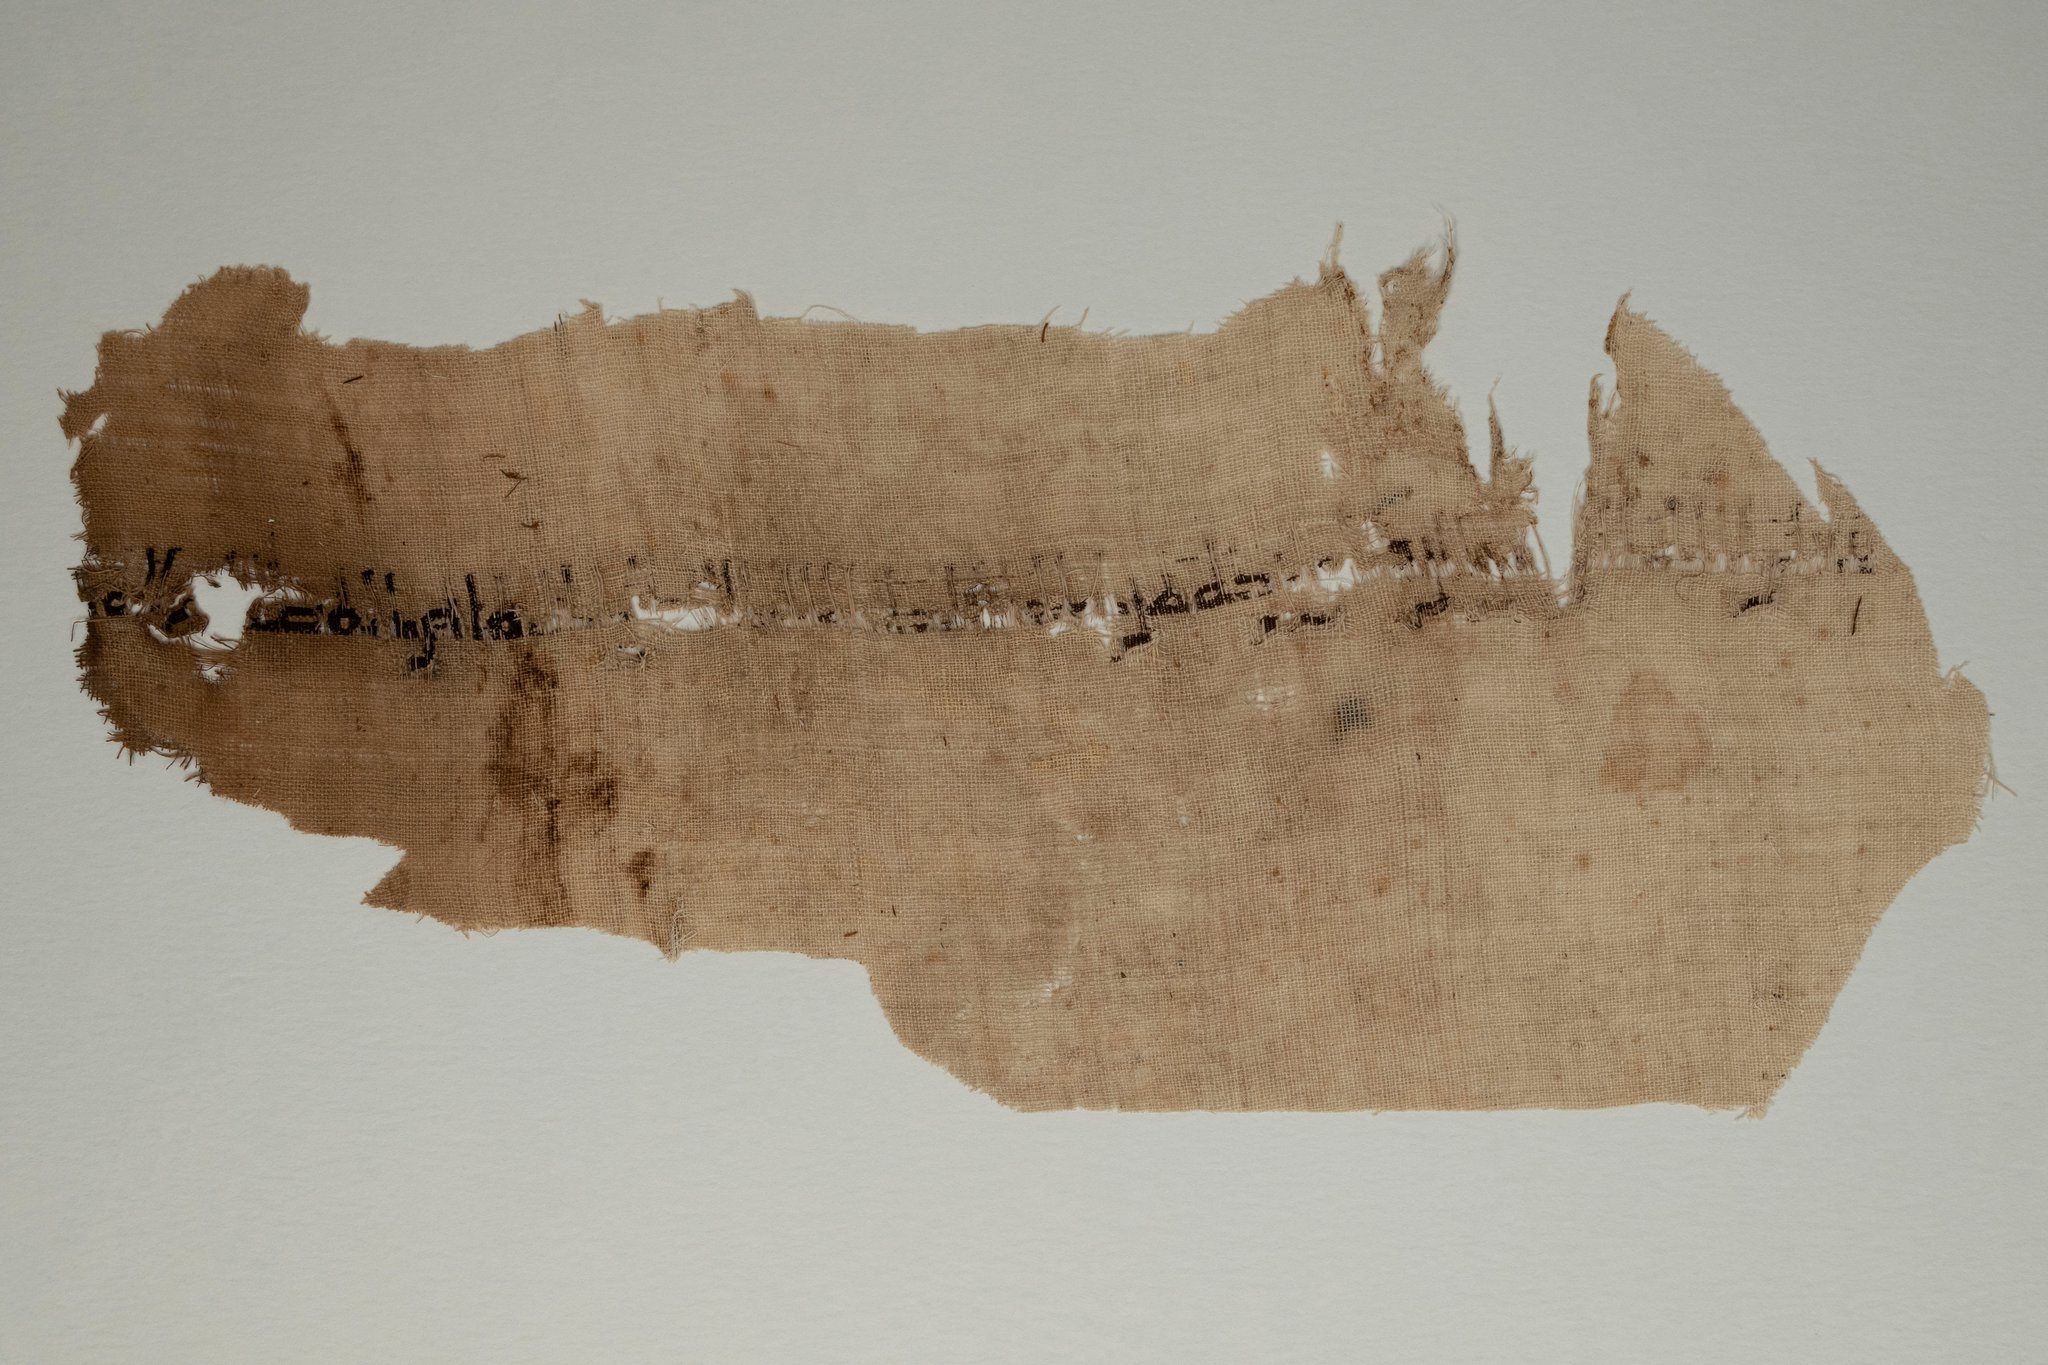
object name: textile fragment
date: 901-1000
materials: linen, silk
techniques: weave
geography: egypt